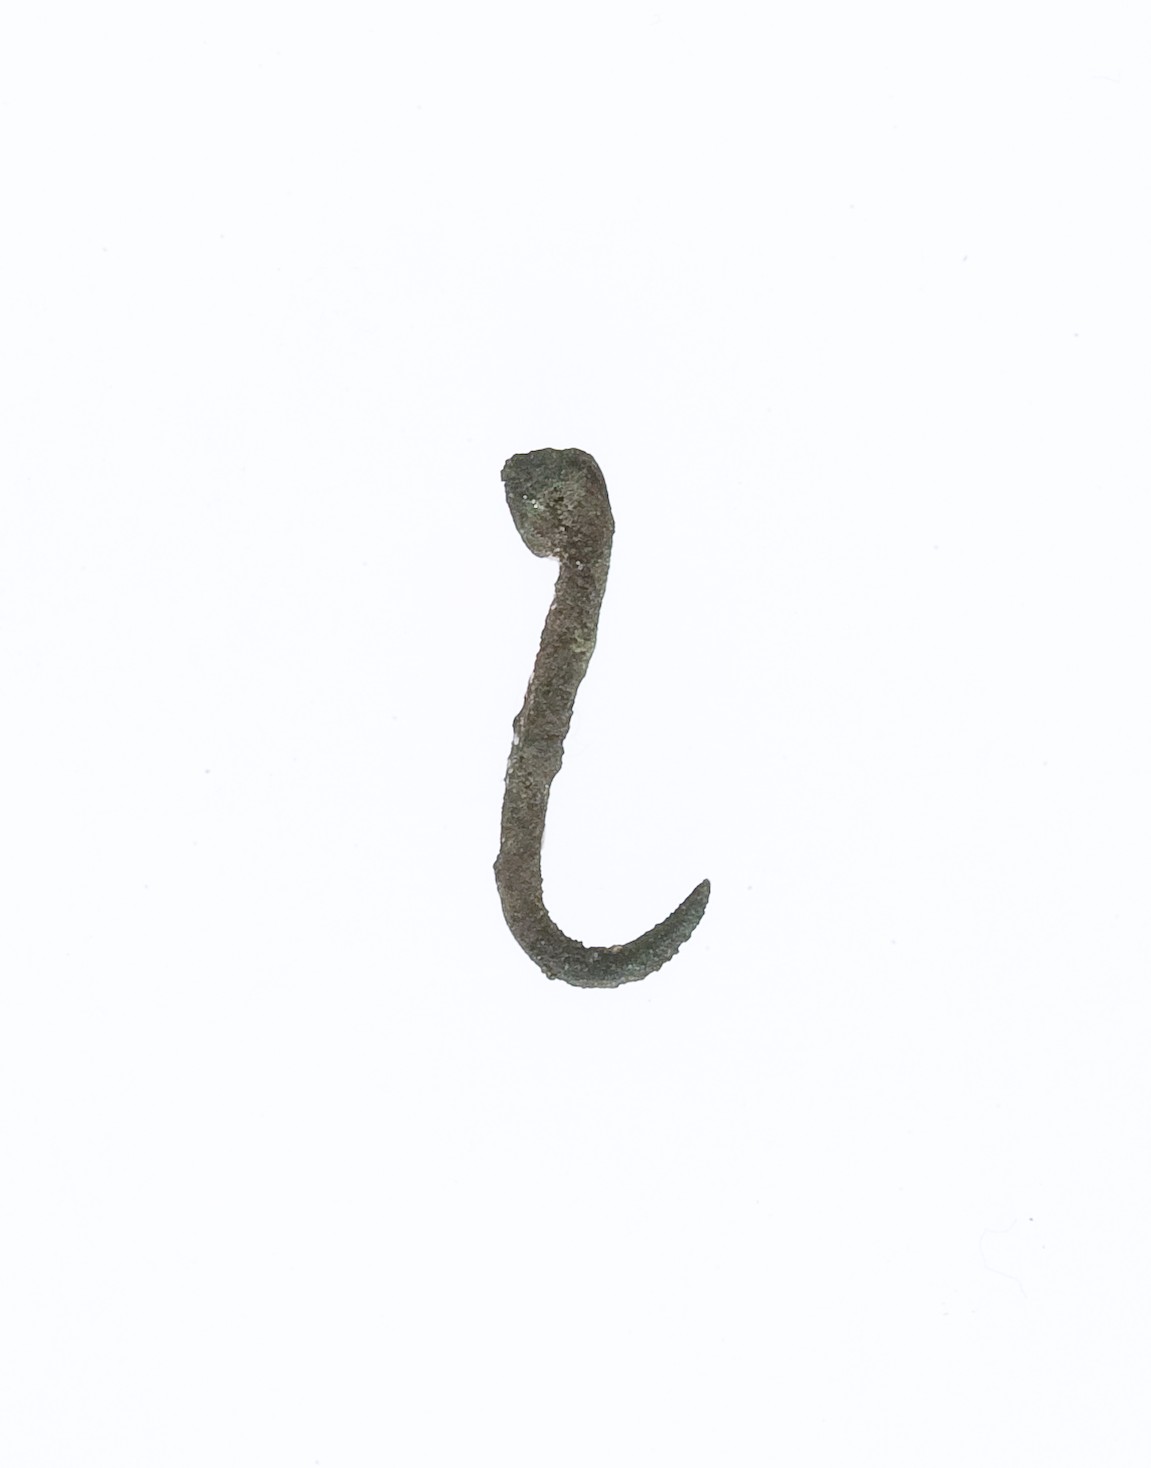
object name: fish hook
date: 1295-1070 BCE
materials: bronze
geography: egypt